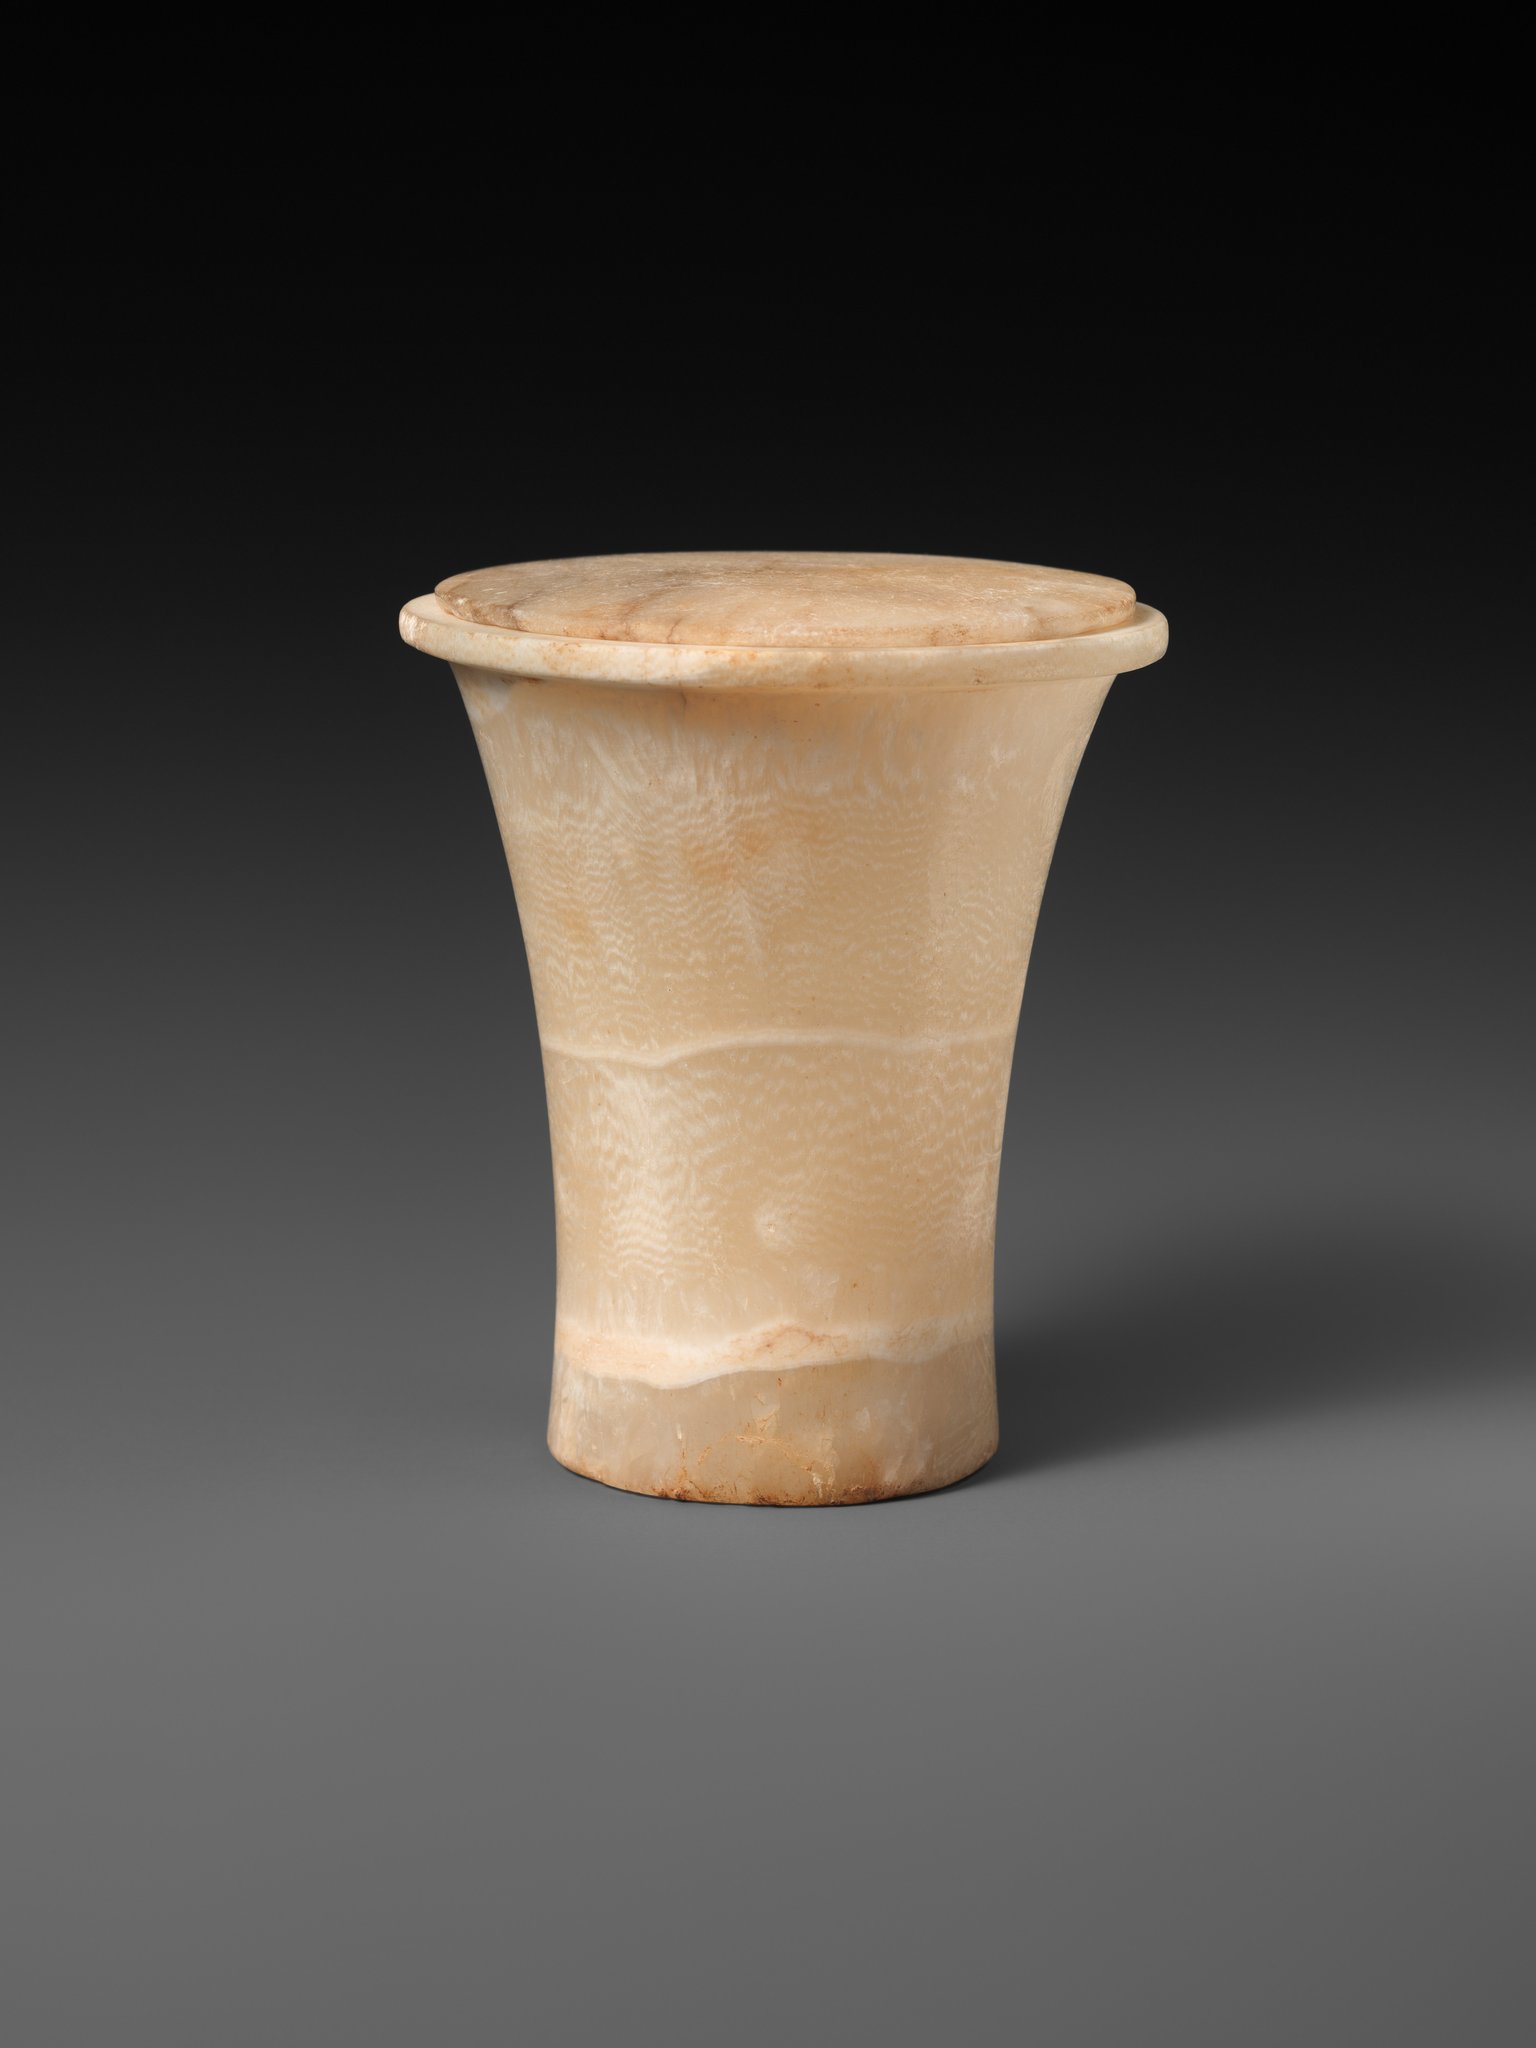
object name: cylindrical unguent vase with a lid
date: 1887-1750 BCE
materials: stone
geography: egypt